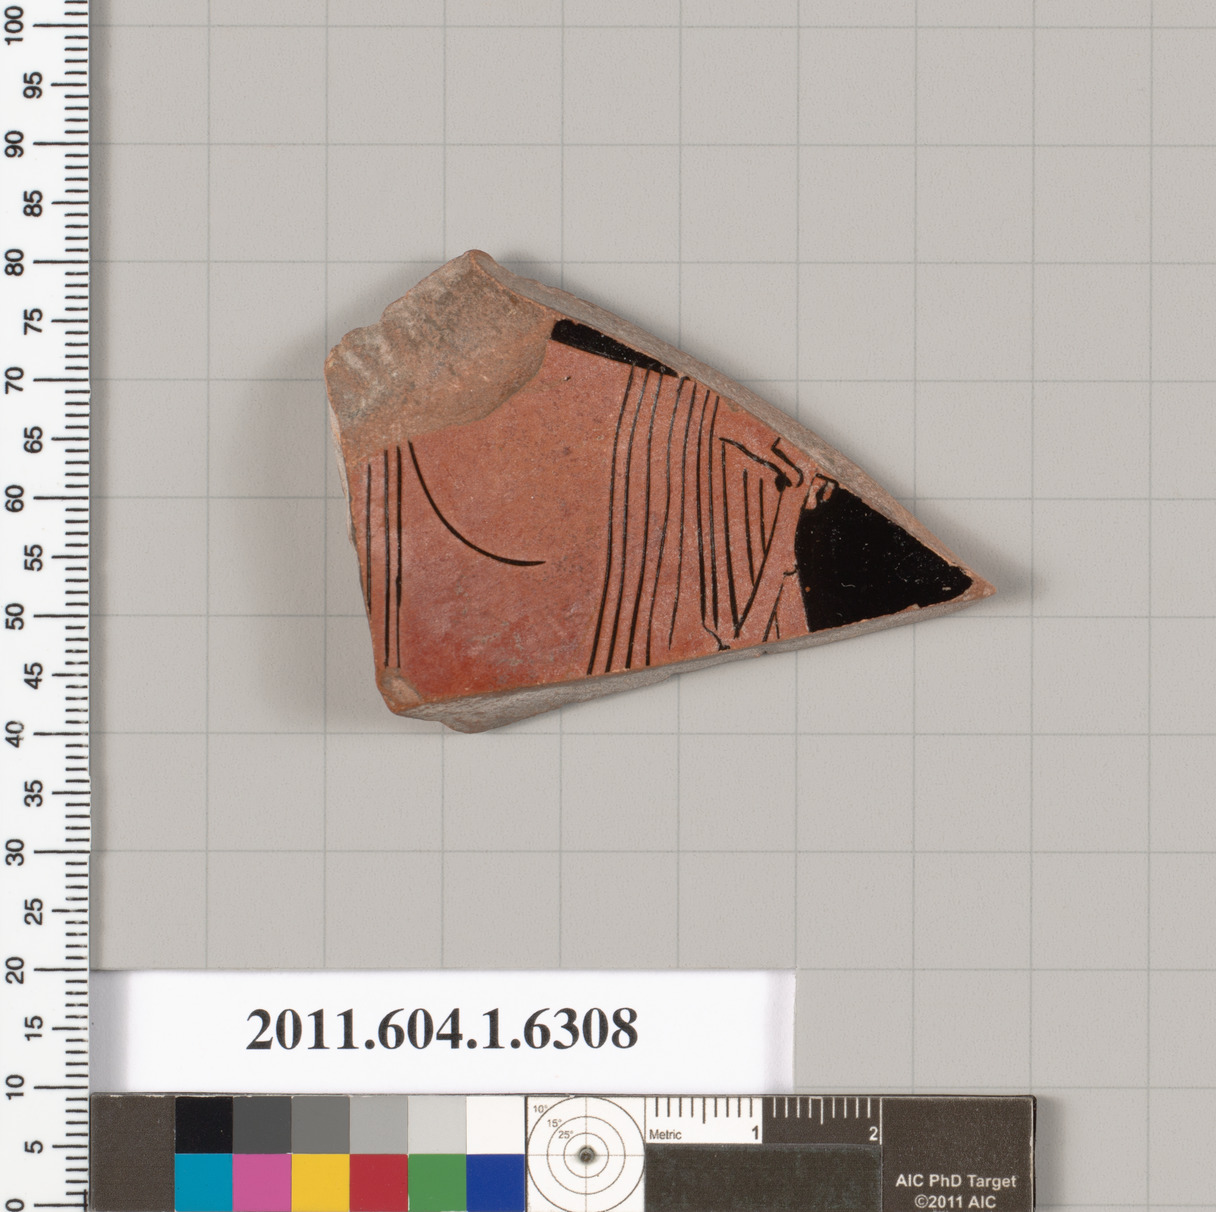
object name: kylix fragment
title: Terracotta fragment of a kylix (drinking cup)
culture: greek, attic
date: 500-480 BCE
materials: terracotta